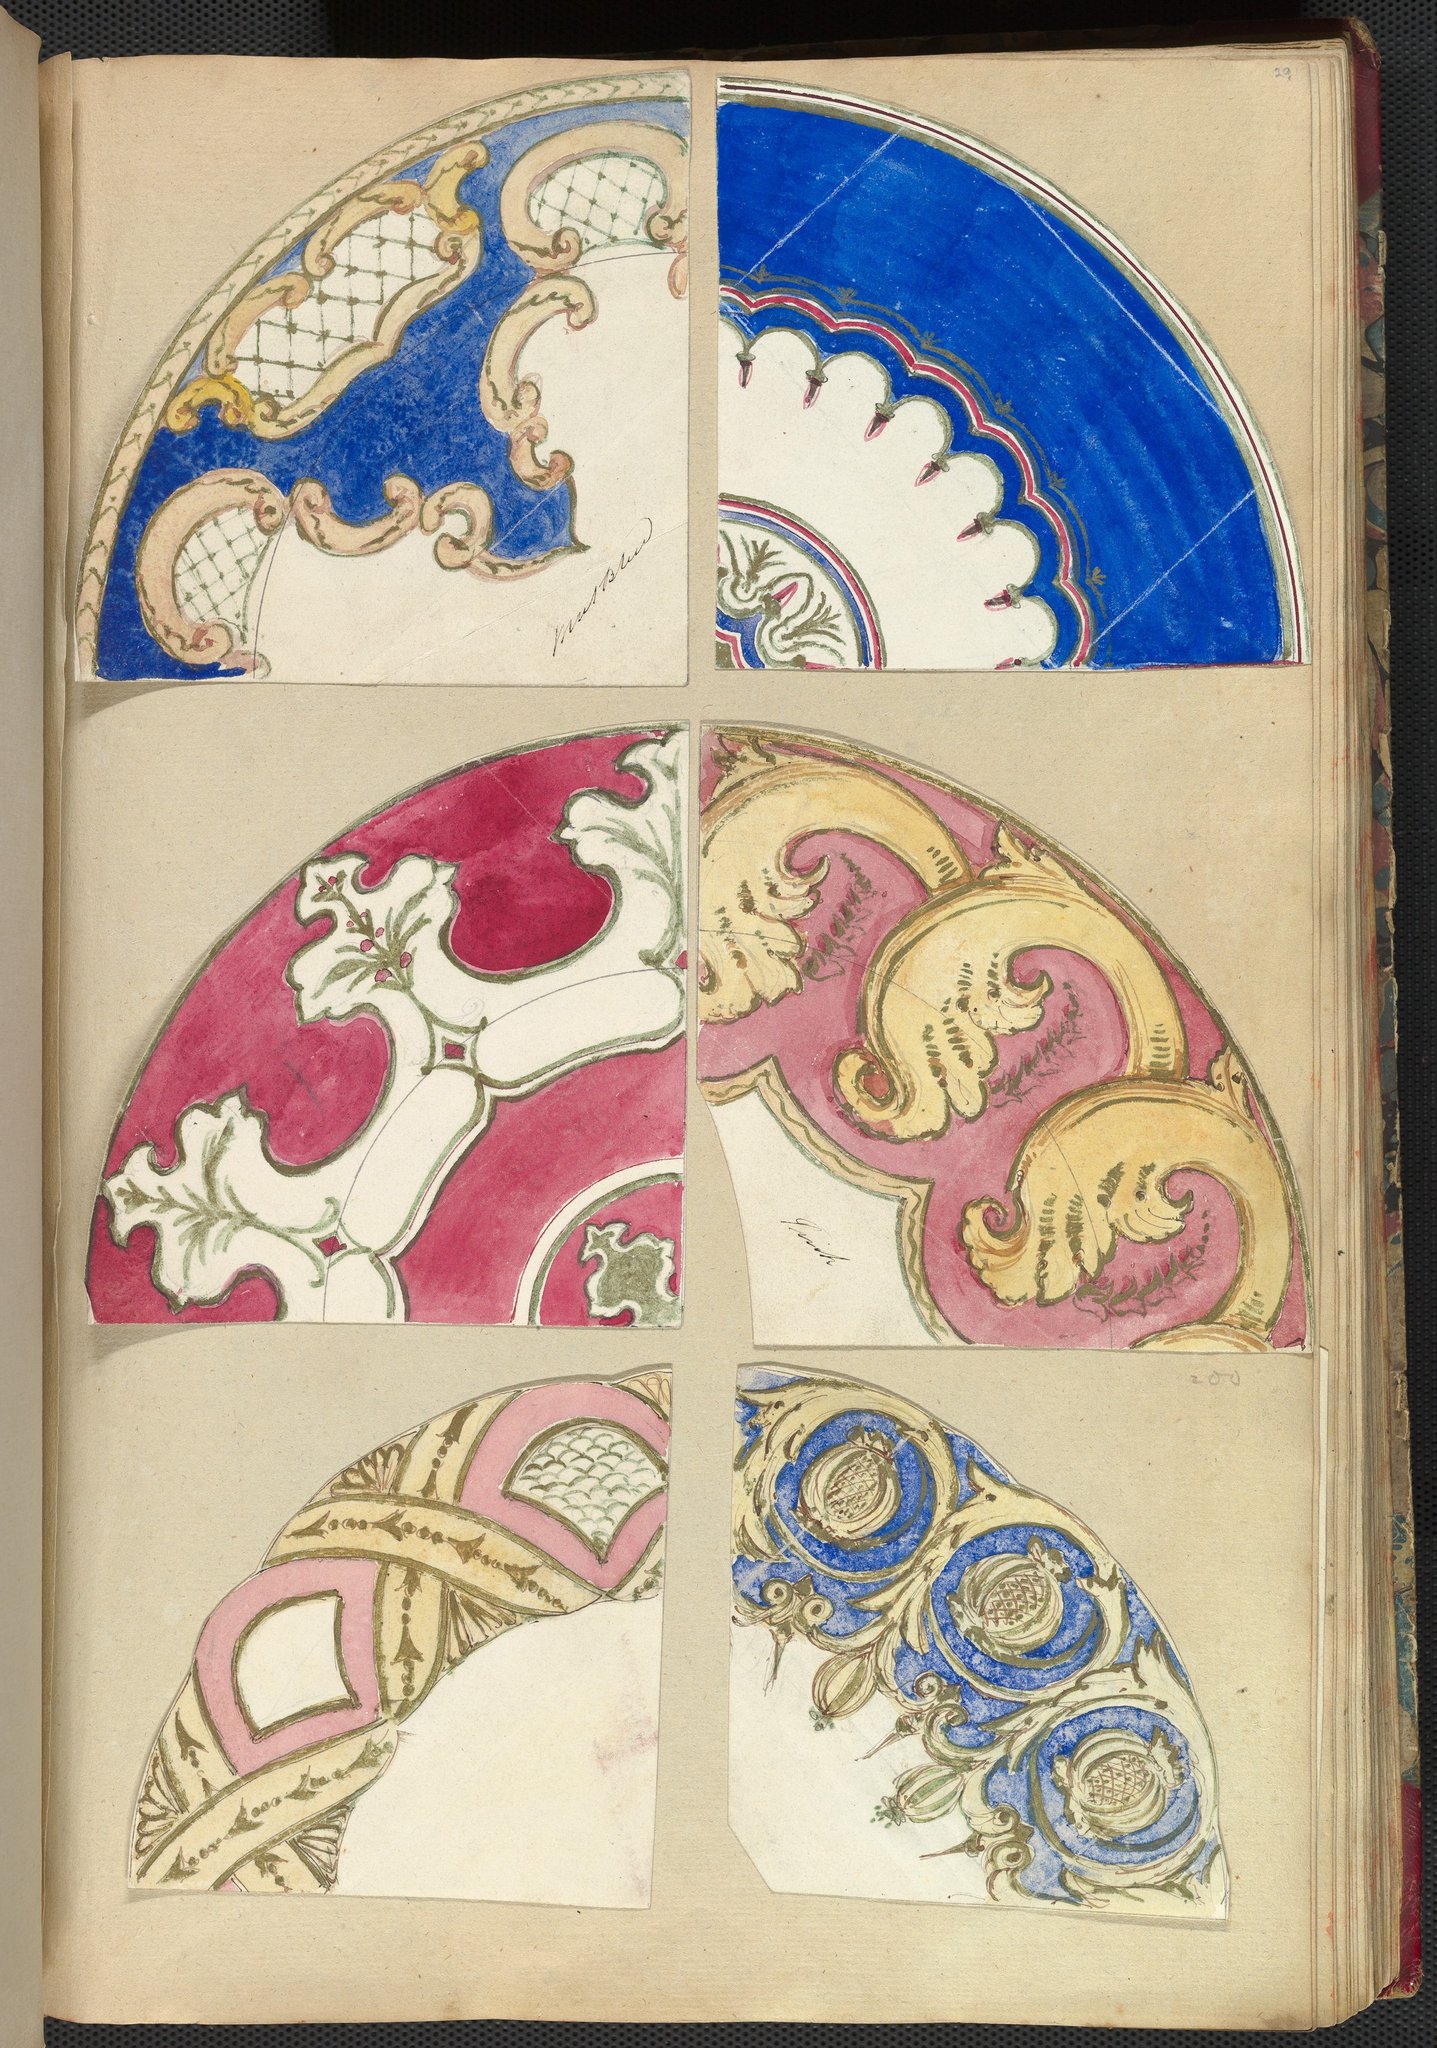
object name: drawing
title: Six Designs for Decorated Plates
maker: alfred henry forrester [alfred crowquill]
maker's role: artist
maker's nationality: british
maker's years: 1804-1872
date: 1845-1855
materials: ink, watercolor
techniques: pen